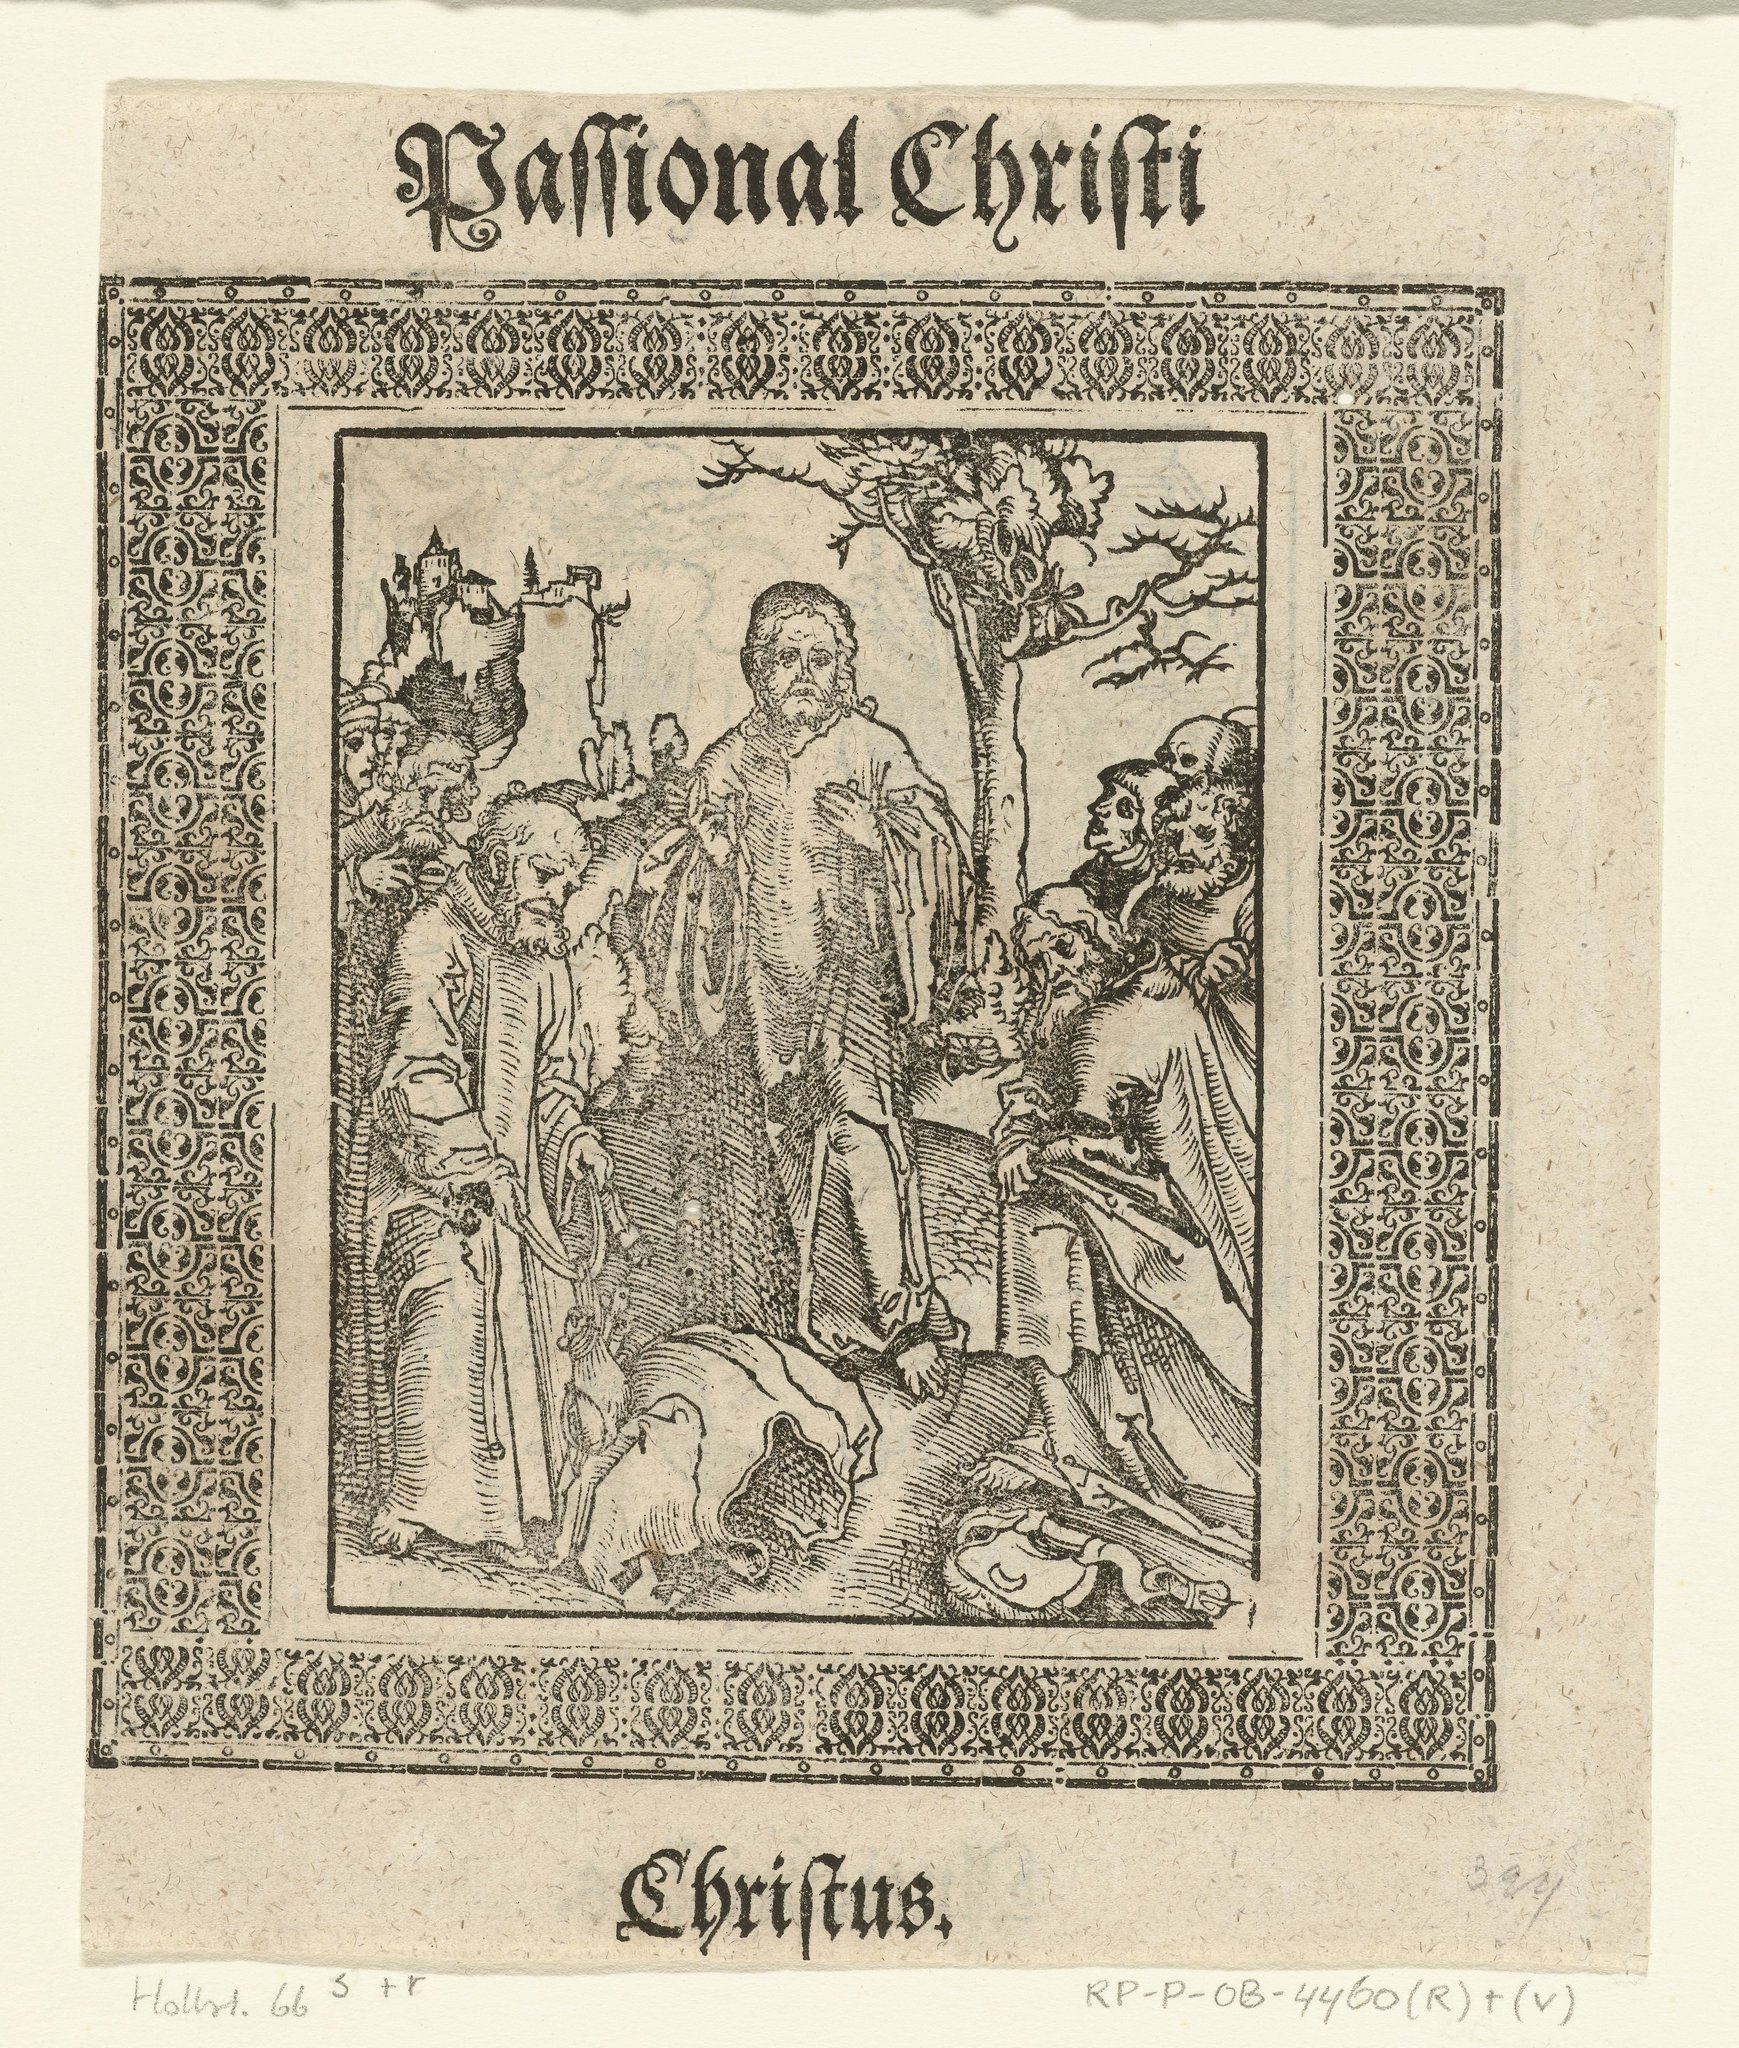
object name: print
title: Christus onderwijst de apostelen om afstand te doen van hun rijkdom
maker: lucas cranach (i)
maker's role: draughtsman, print maker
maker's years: 1472-1553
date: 1521-1522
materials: paper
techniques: woodcut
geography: wittenberg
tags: doctrine of christ ~ possessions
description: De tegenhanger van deze prent is de voorstelling Gezag van paus over bisschop, zie RP-P-OB-4461(V). Blad uit: Passional Christi und Antichristi, Wittenberg 1521-1522, Johann Grünenberg. In 1521-1522 verschenen veel verschillende uitgaven van dit populaire werk van Maarten Luther. In de collectie van het RMA bevindt zich de complete serie van zesentwintig afbeeldingen uit een van deze uitgaven. De pagina's zijn op een kleiner formaat gesneden, onder iedere voorstelling stond oorspronkelijk een aantal regels Duitse tekst. De bladen hebben allemaal op dezelfde plaats twee kleine gaatjes van vraat door ongedierte wat er op wijst dat ze behoren tot hetzelfde exemplaar.